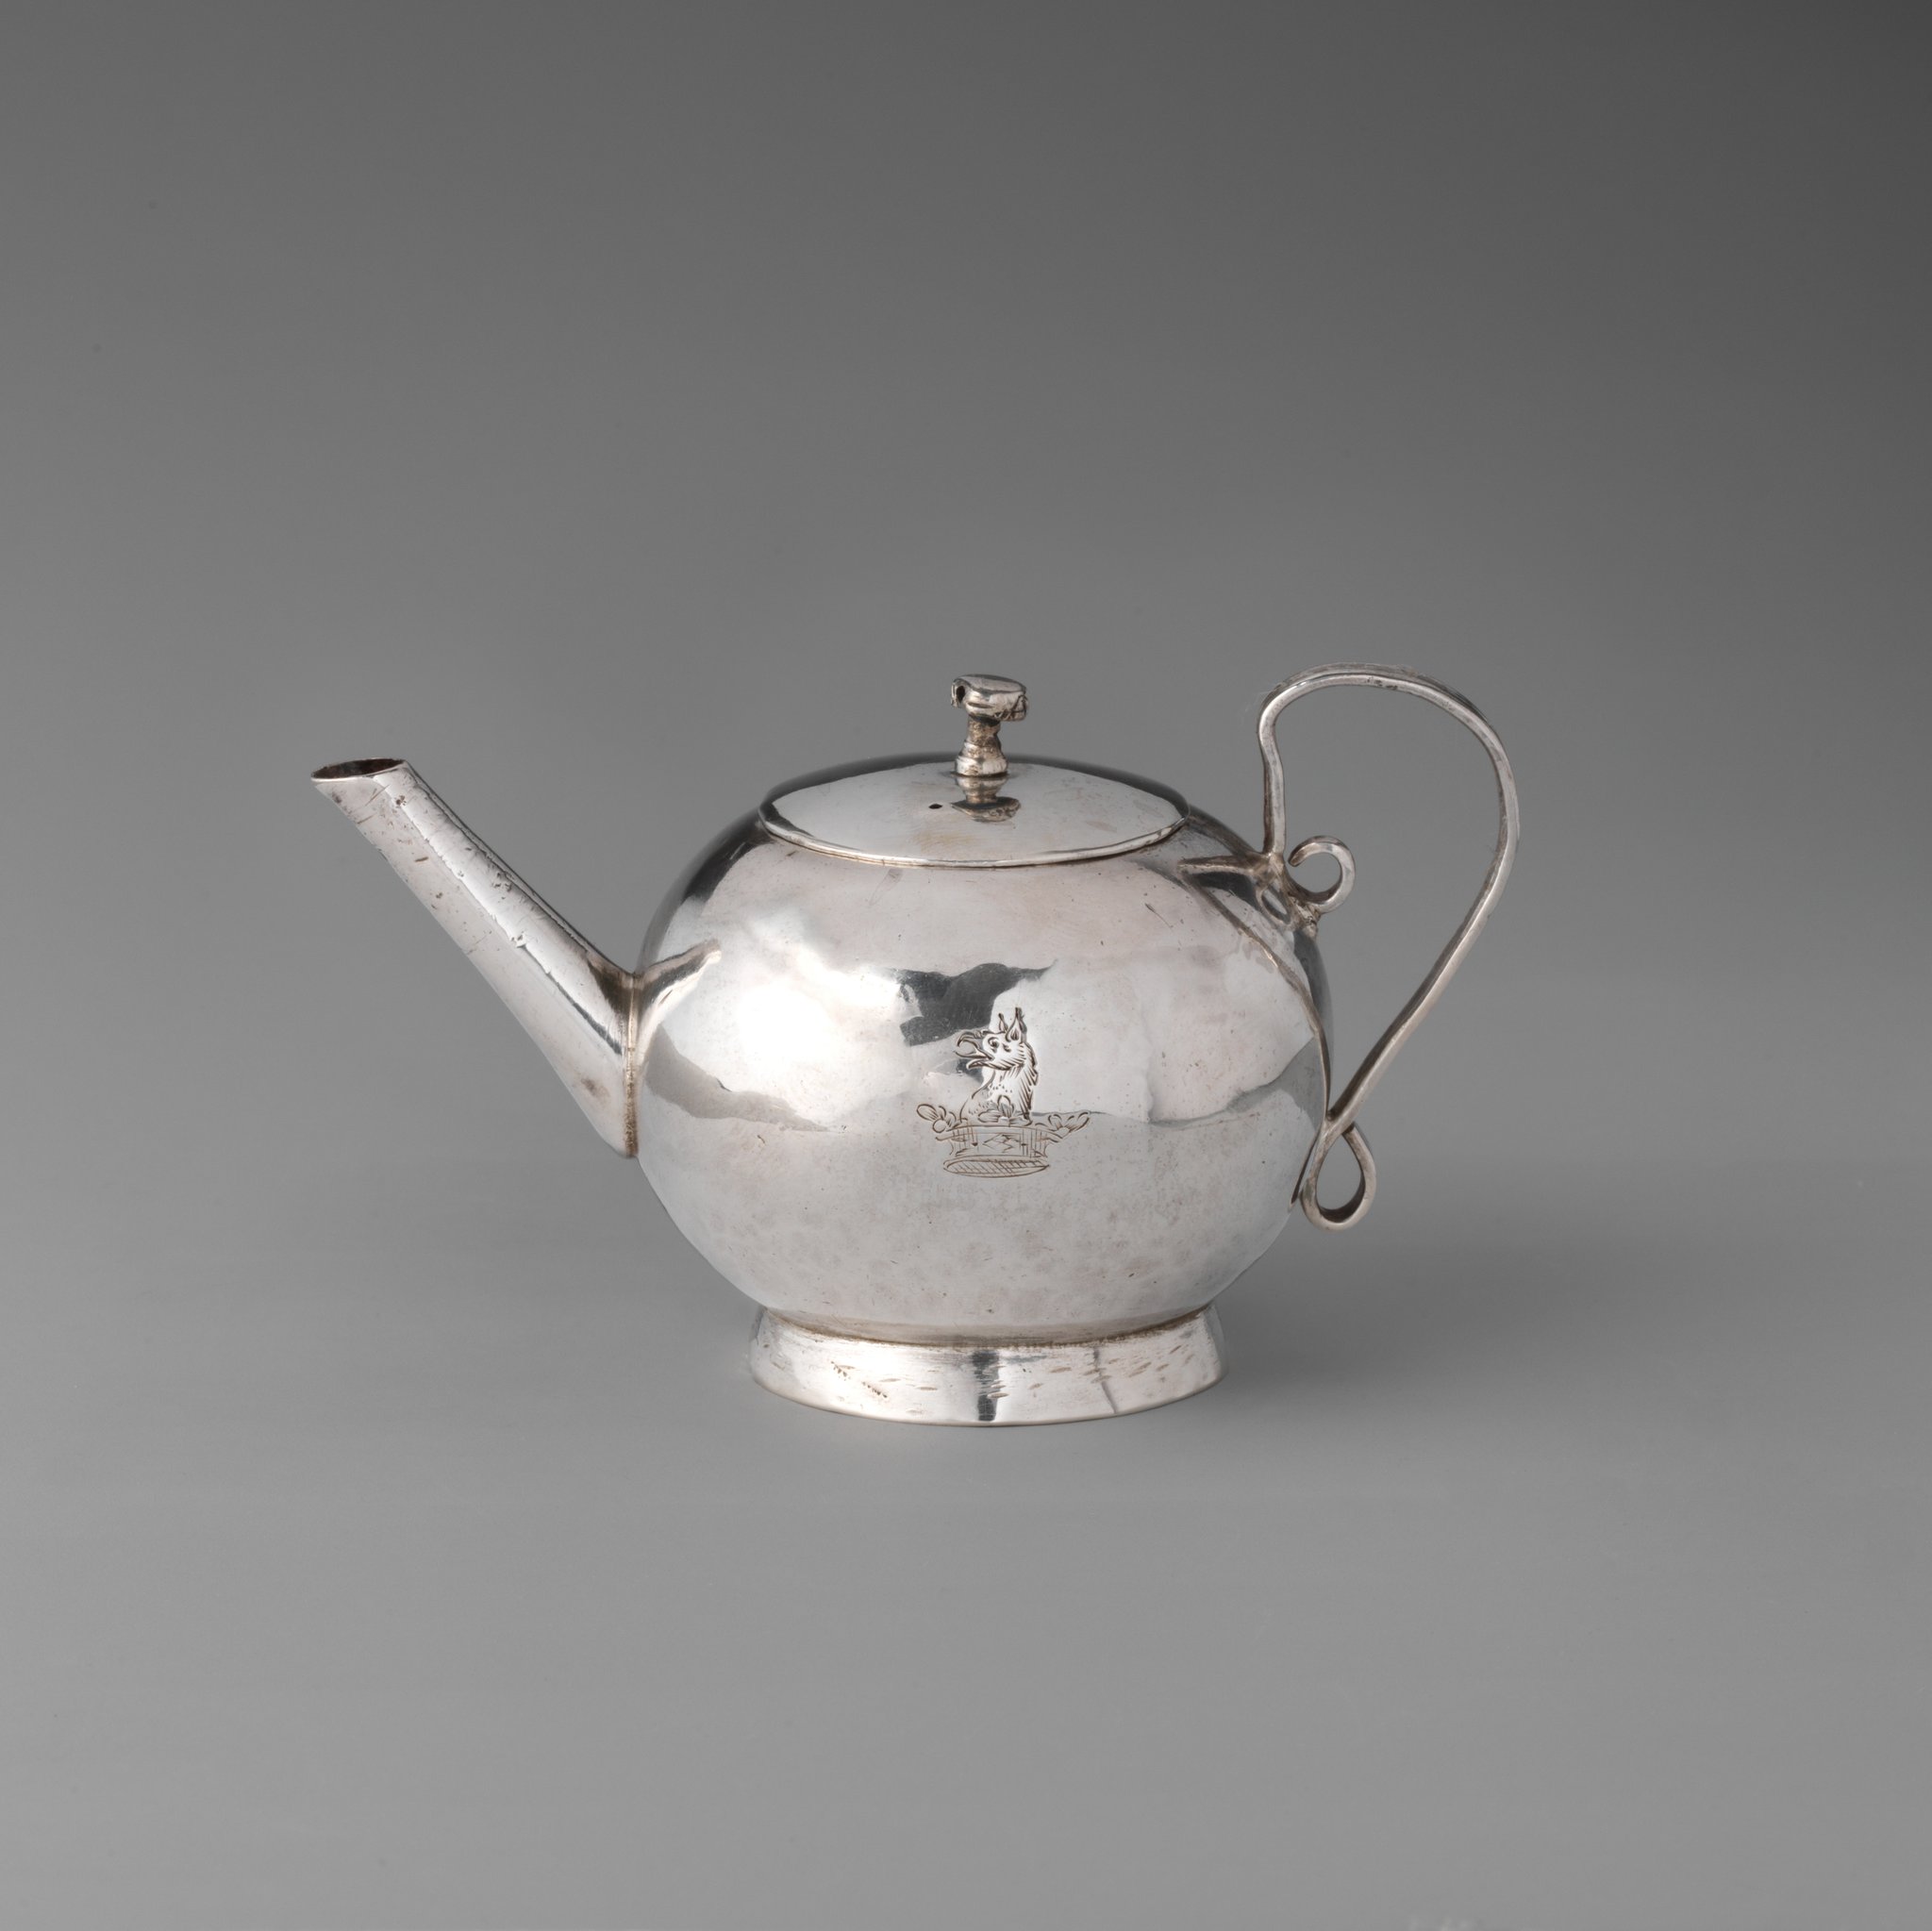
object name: teapot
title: Miniature teapot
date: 1701-1800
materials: silver